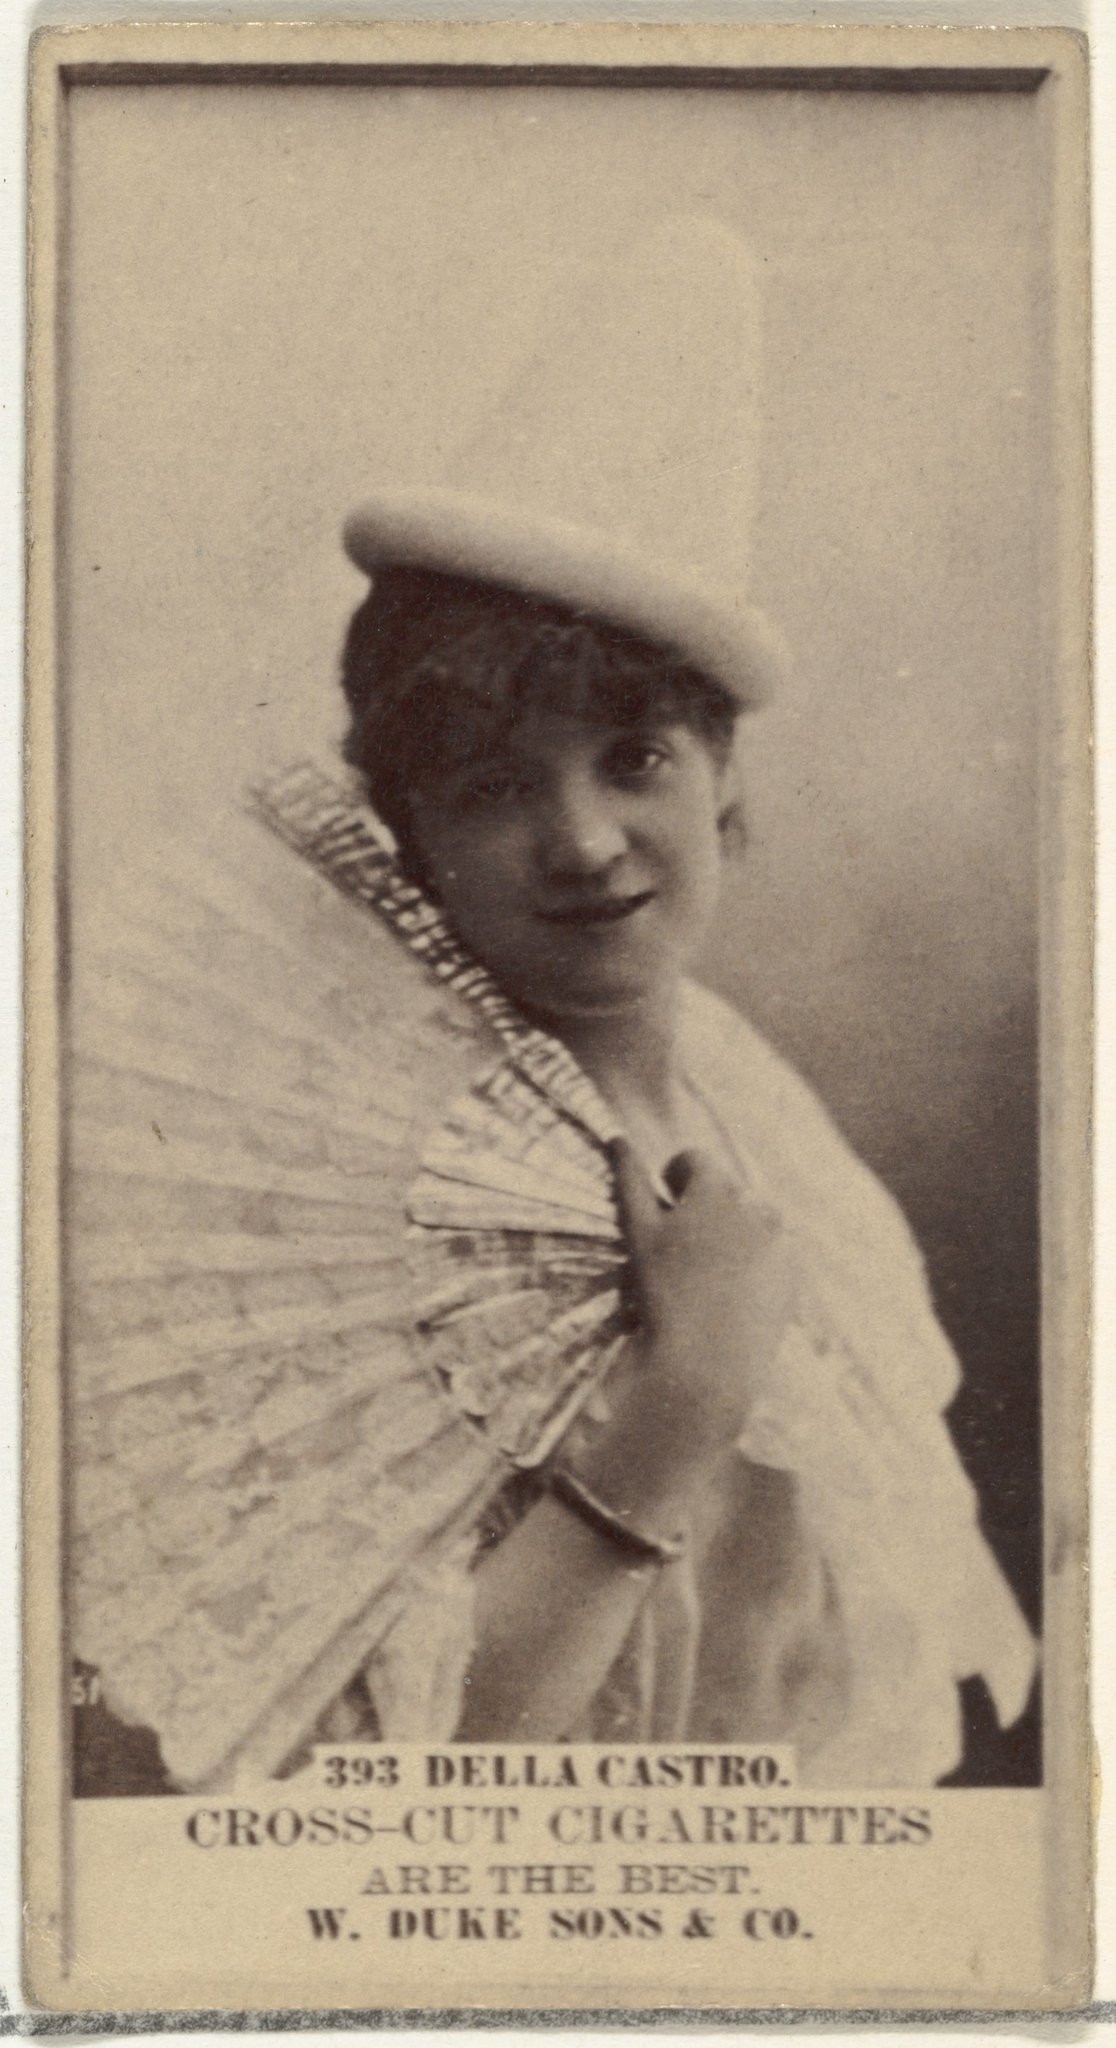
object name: photograph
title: Card Number 393, Della Castro, from the Actors and Actresses series (N145-3) issued by Duke Sons & Co. to promote Cross Cut Cigarettes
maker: w. duke, sons & co.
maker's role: publisher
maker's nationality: american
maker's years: 1870-1920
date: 1880-1889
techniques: albumen silver print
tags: portraits,women,actresses